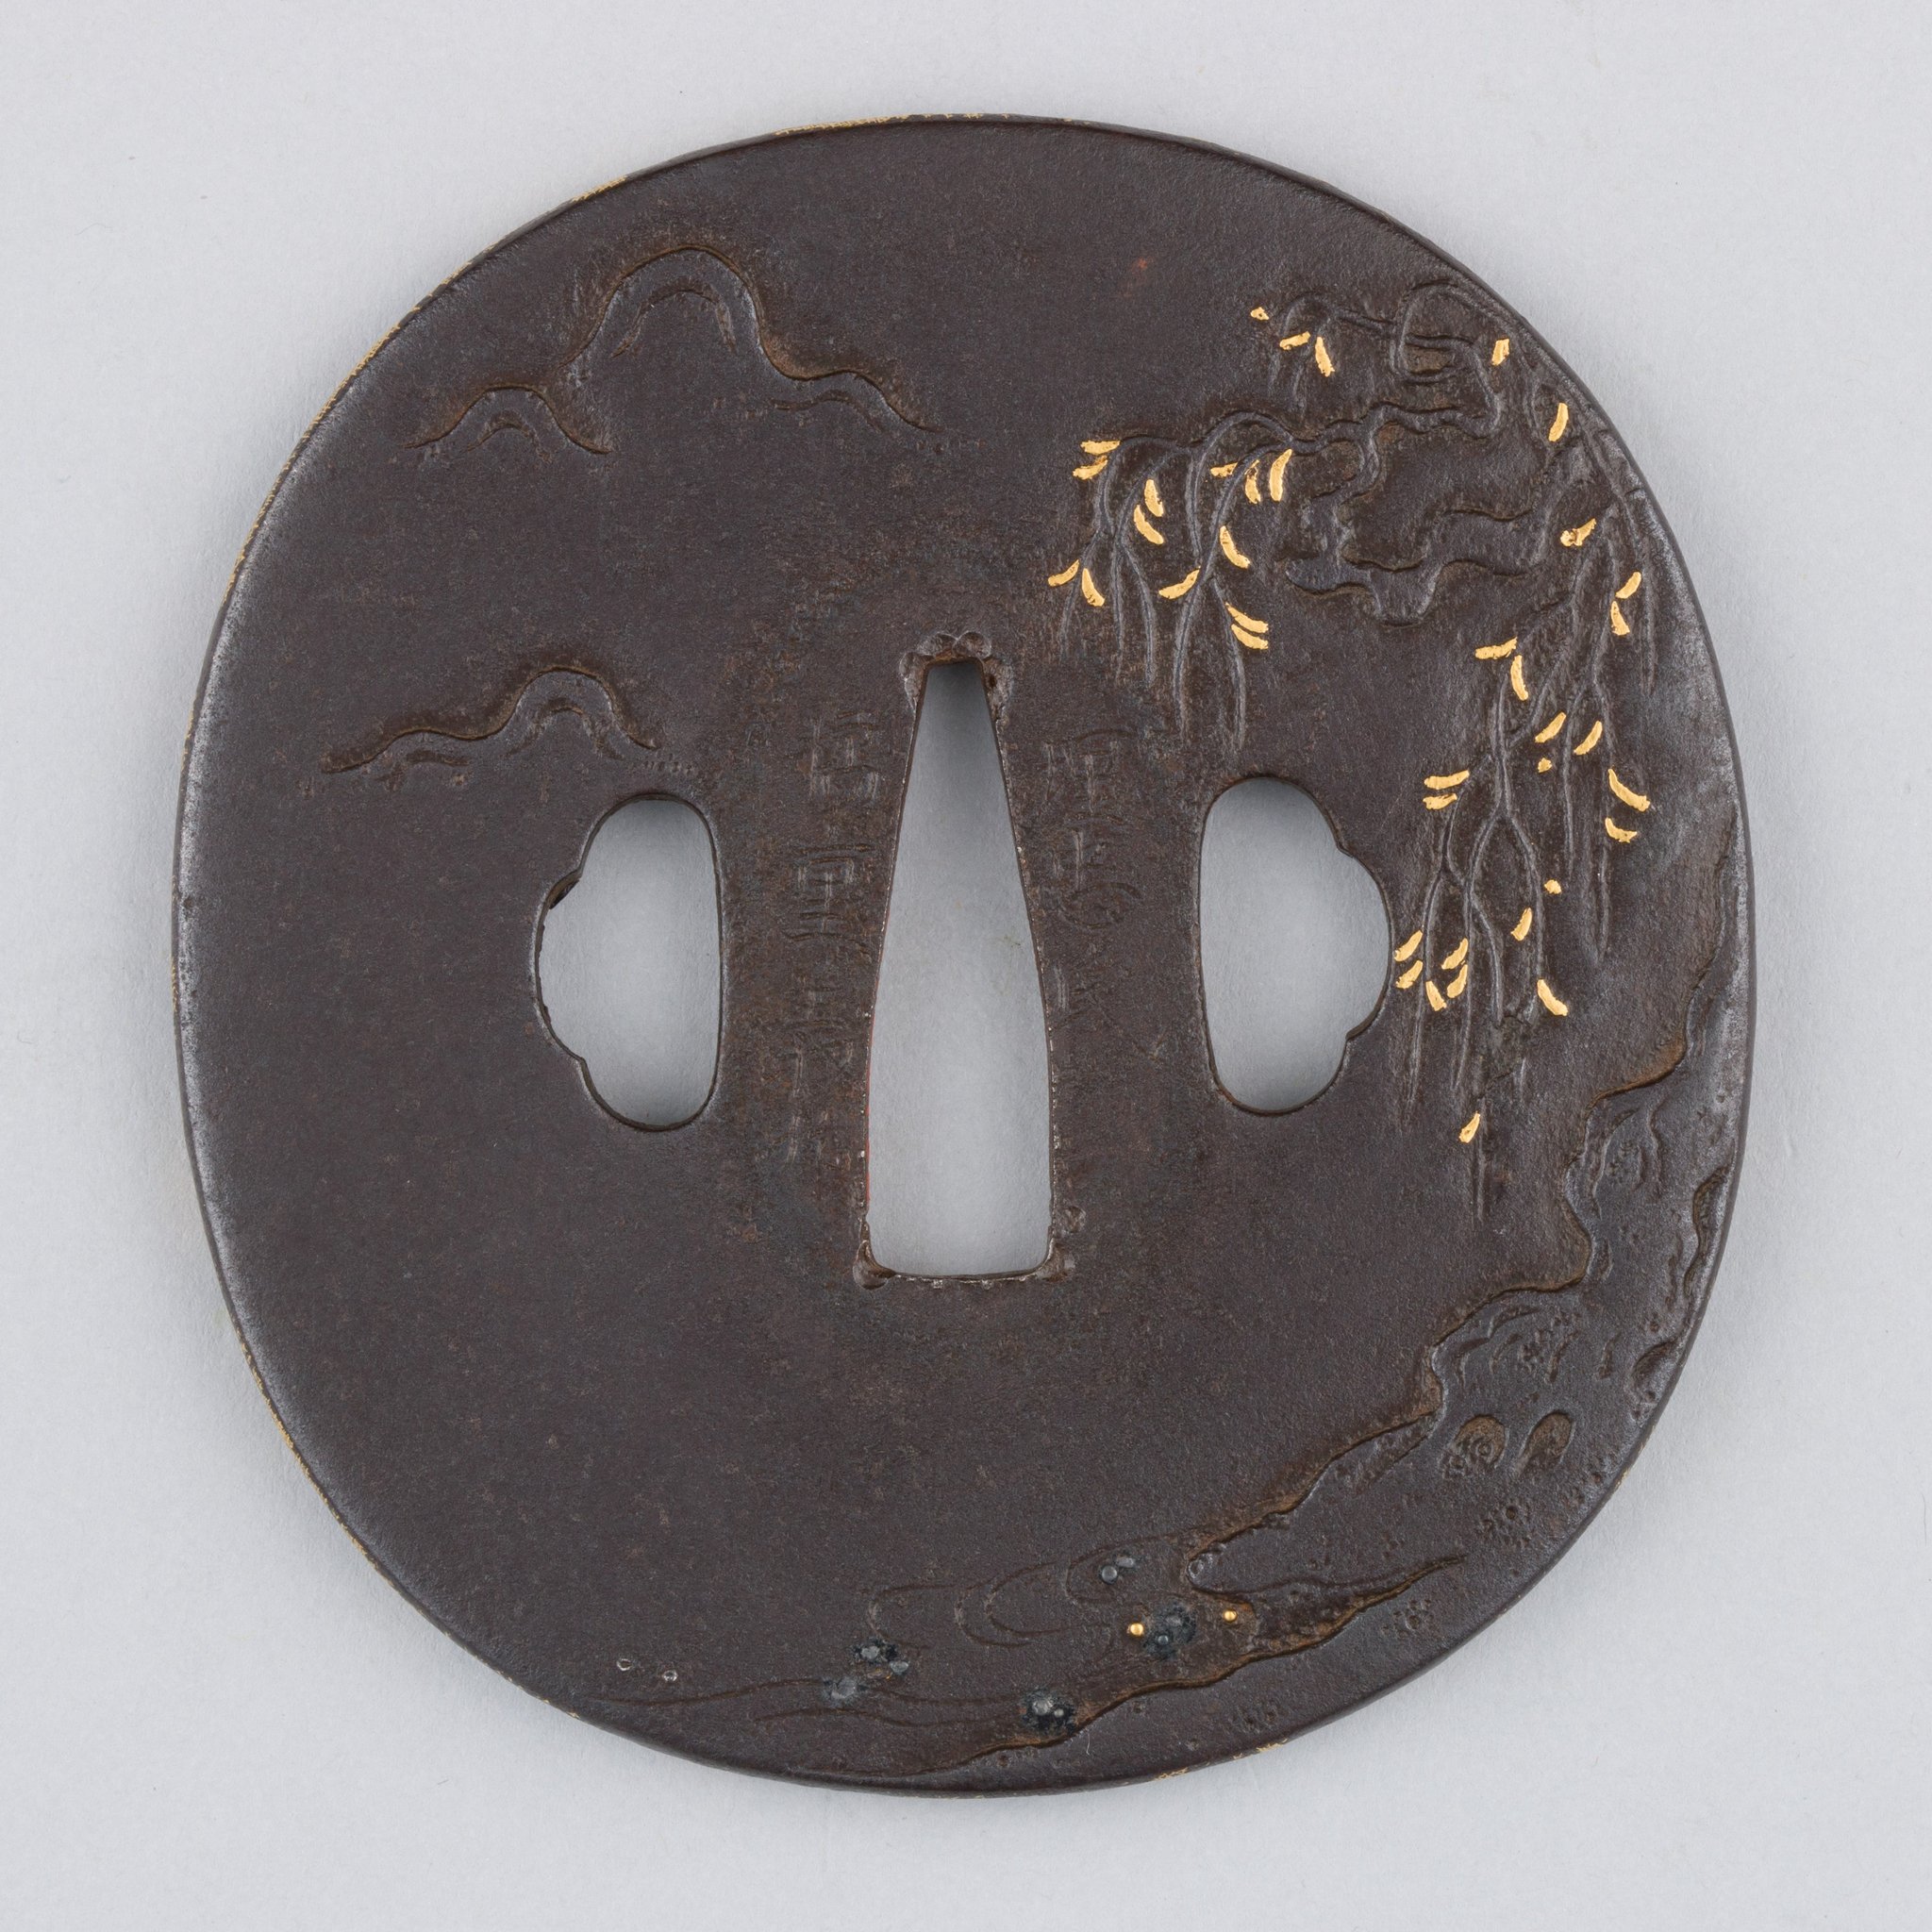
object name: sword guard tsuba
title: Sword Guard (Tsuba)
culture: japanese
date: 1667-1700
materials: copper, gold, iron, silver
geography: japan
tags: plants